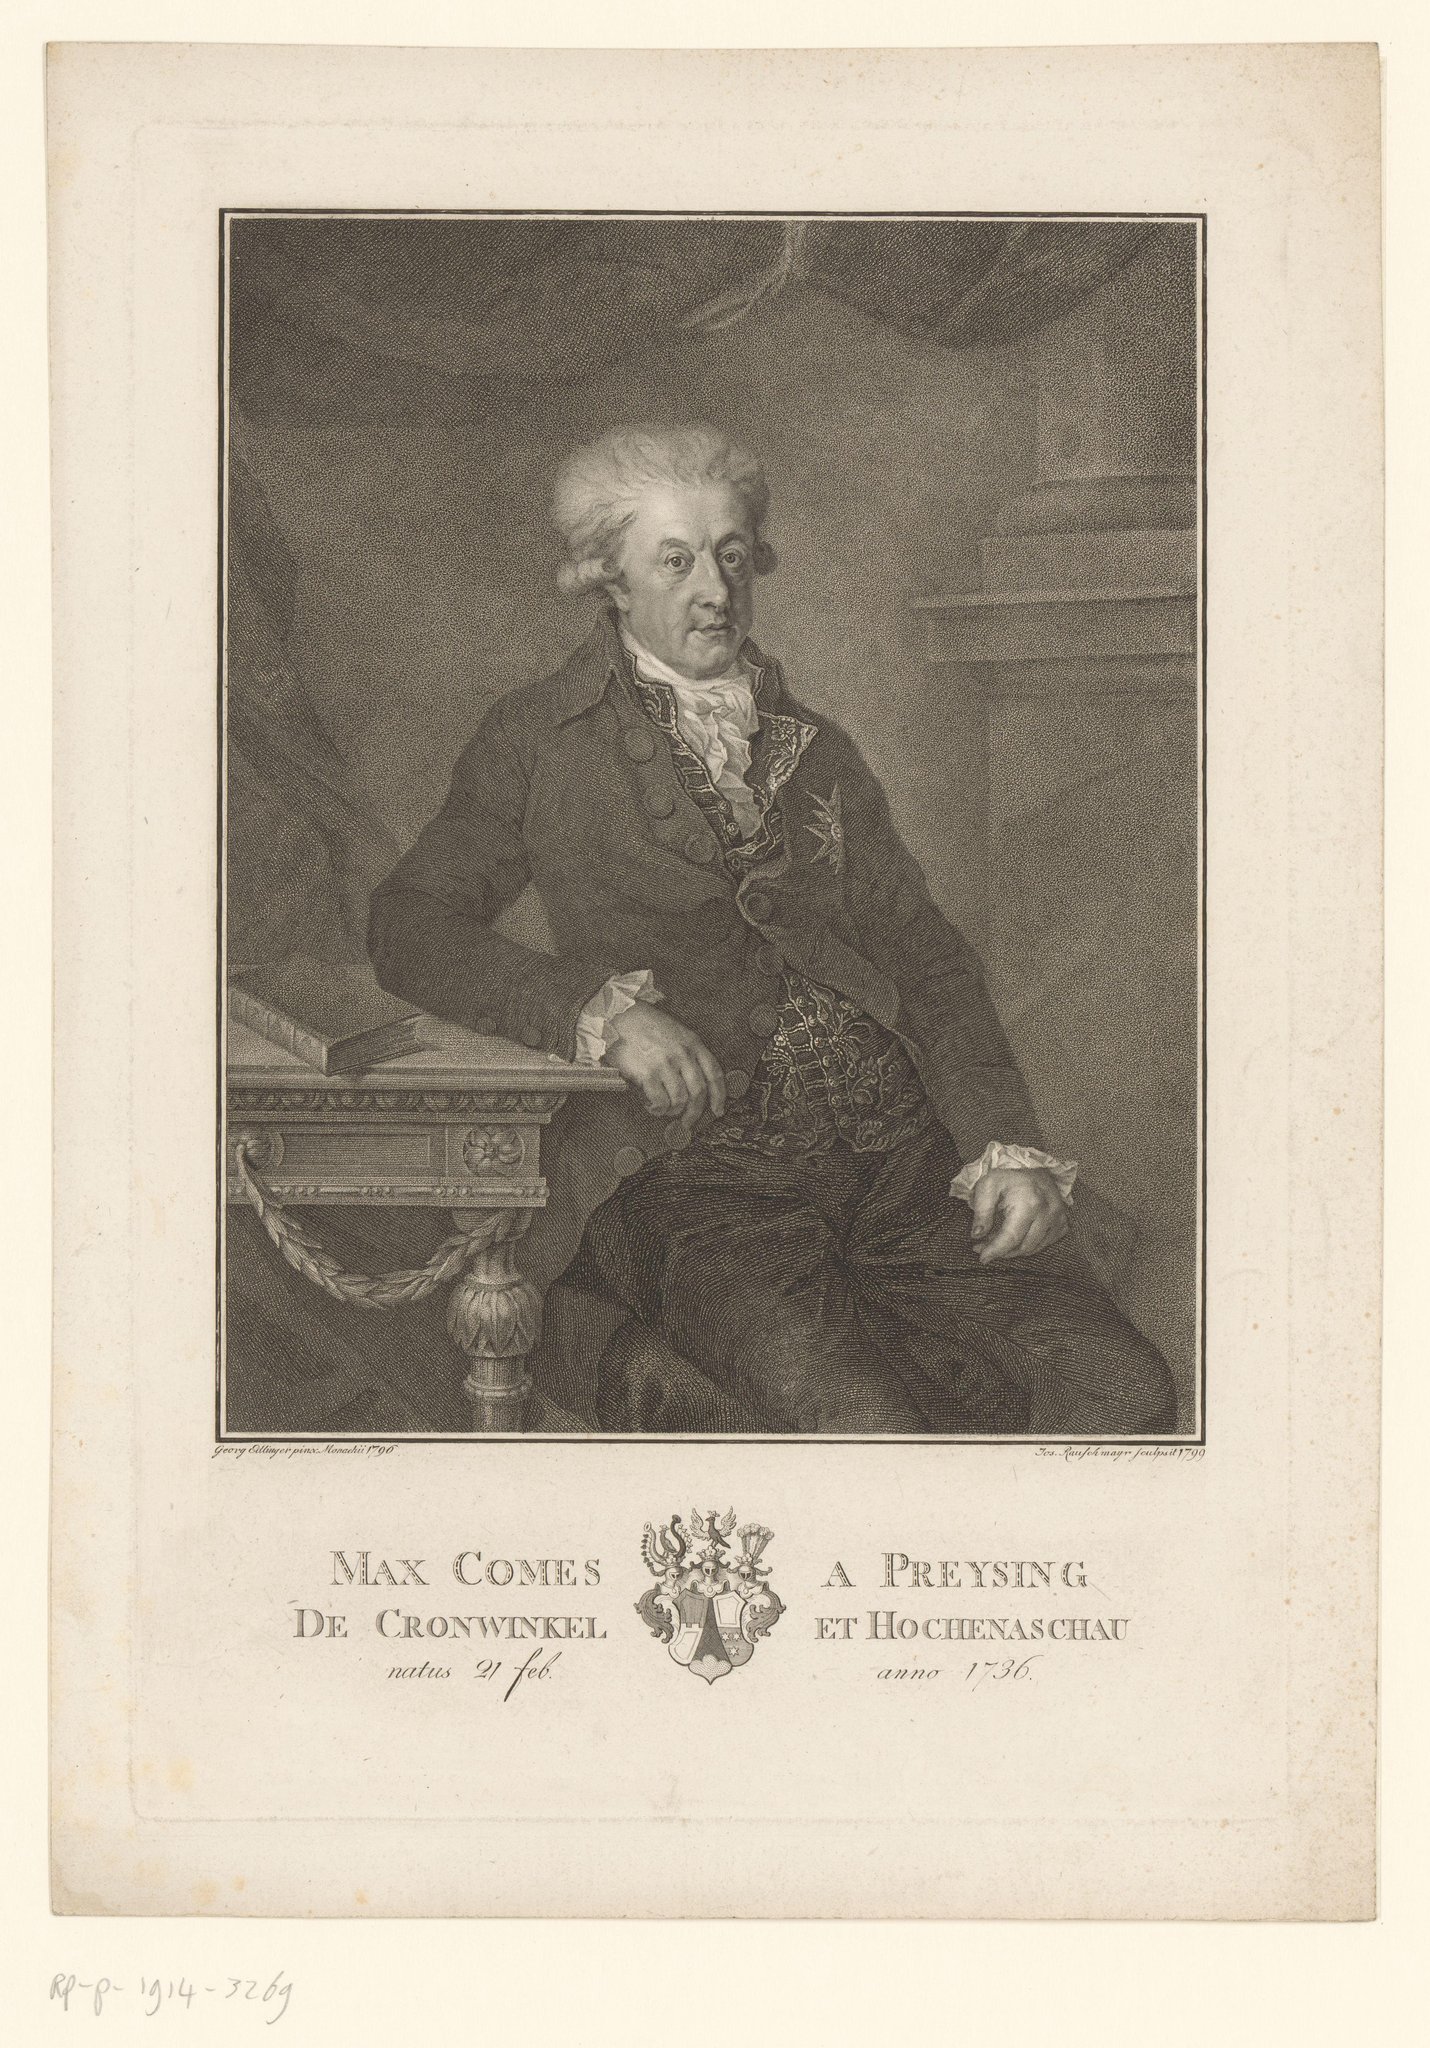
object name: print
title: Portret van Maximilian Johann Franz Graf von Preysing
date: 1768-1815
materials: paper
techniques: engraving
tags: knighthood order (red eagle order), historical persons, book, armorial bearing, heraldry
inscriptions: collector's mark: Lugt 2228